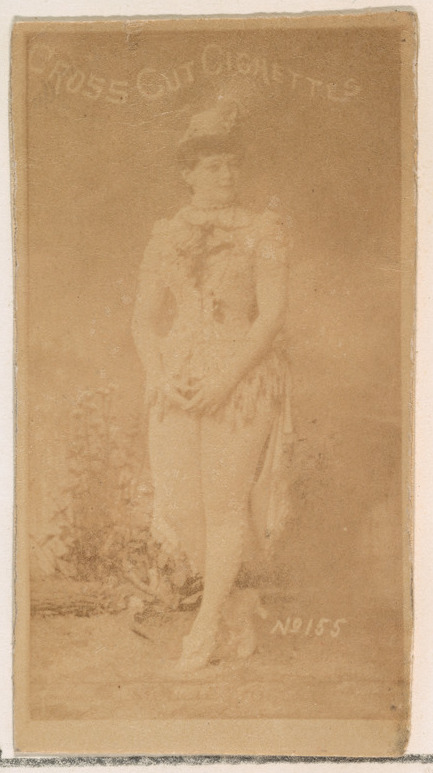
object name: print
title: Card Number 155, from the Actors and Actresses series (N145-1) issued by Duke Sons & Co. to promote Cross Cut Cigarettes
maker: w. duke, sons & co.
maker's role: publisher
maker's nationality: american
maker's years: 1870-1920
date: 1880-1889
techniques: albumen silver print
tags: portraits,women,actresses